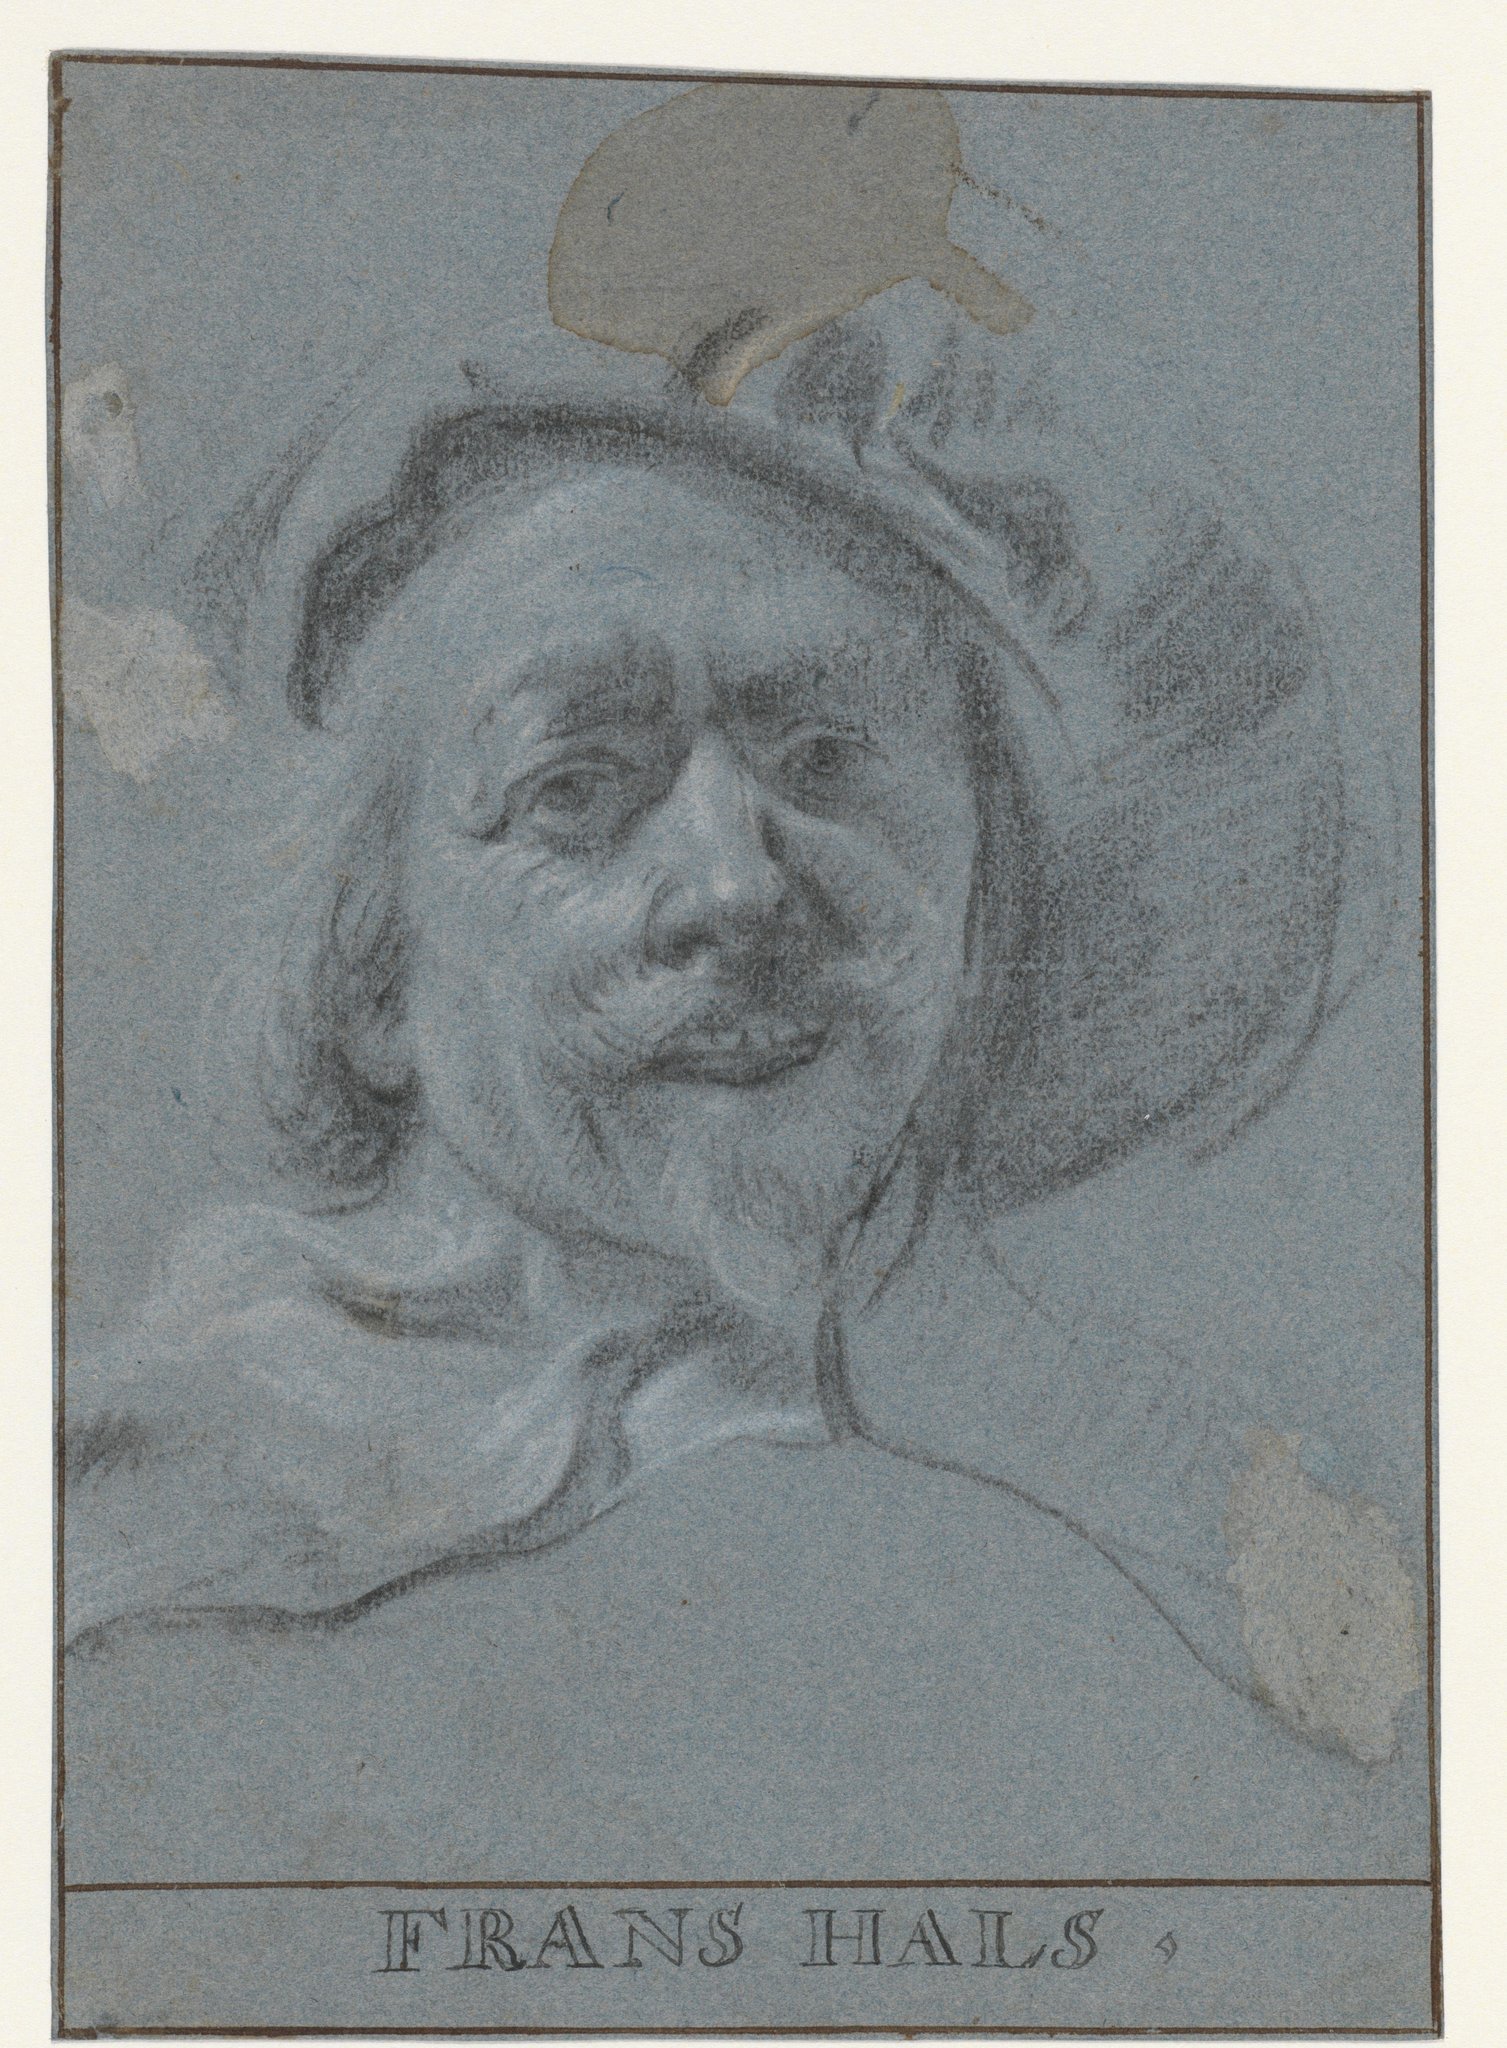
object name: design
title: Portret van Frans Hals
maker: Anonymous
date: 1700-1900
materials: chalk, paper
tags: haarlem, frans hals, historical persons, portrait, self-portrait of painter, portrait, self-portrait of artist, portrait, self-portrait of draughtsman